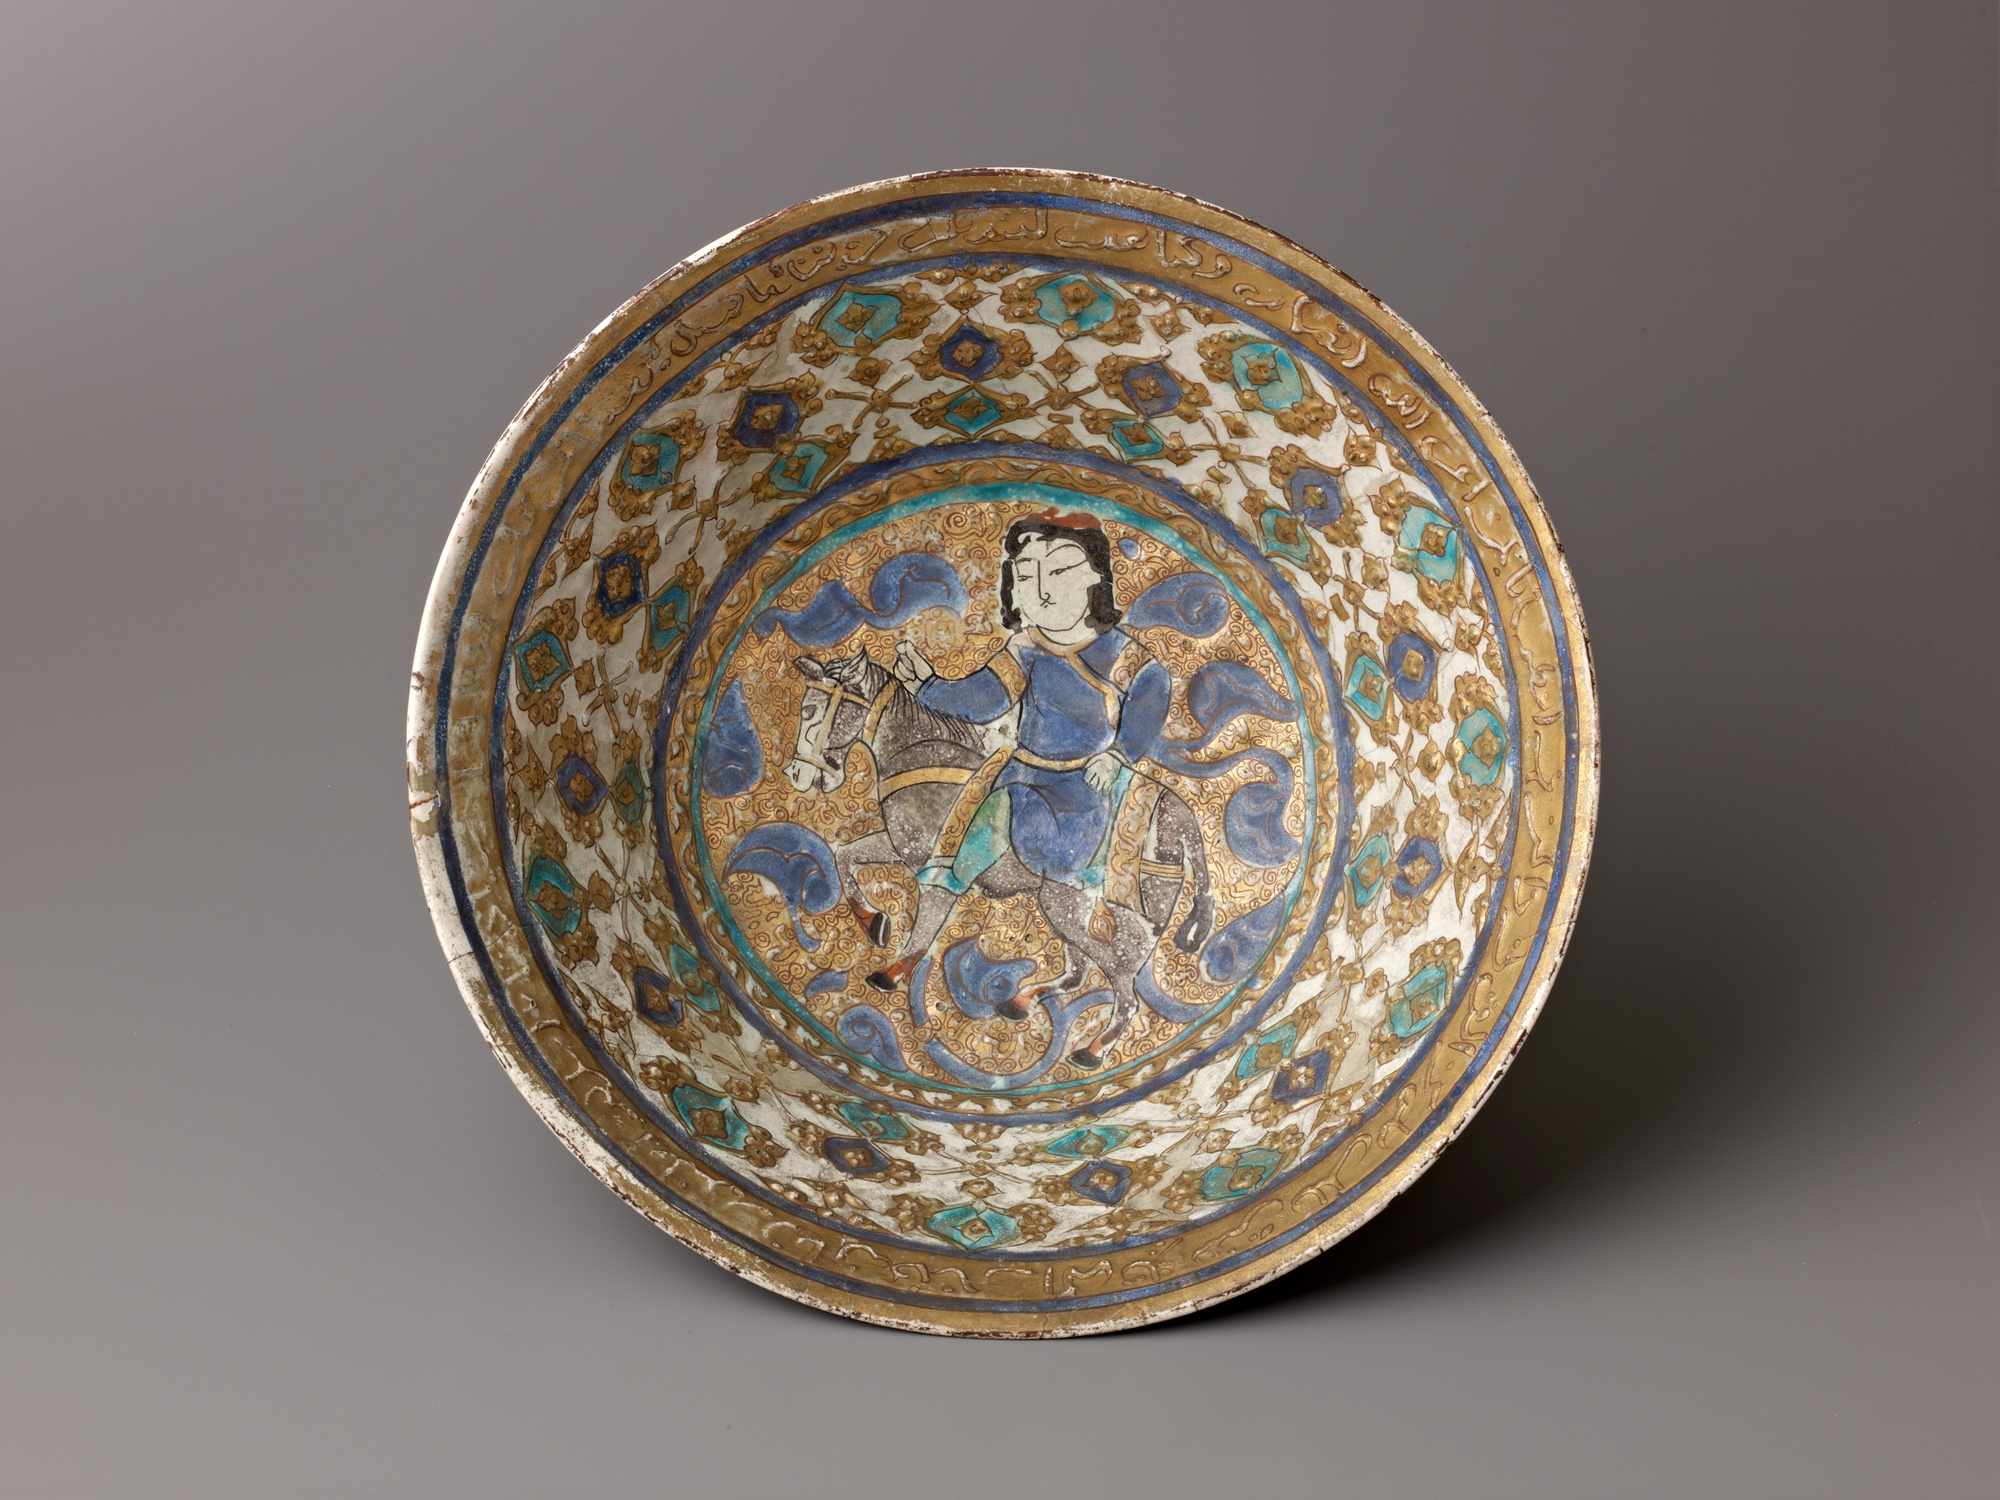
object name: bowl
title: Bowl, Mina'i ("enameled") ware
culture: iranian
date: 1201-1233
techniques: gilding, overglaze, painting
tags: men,horses